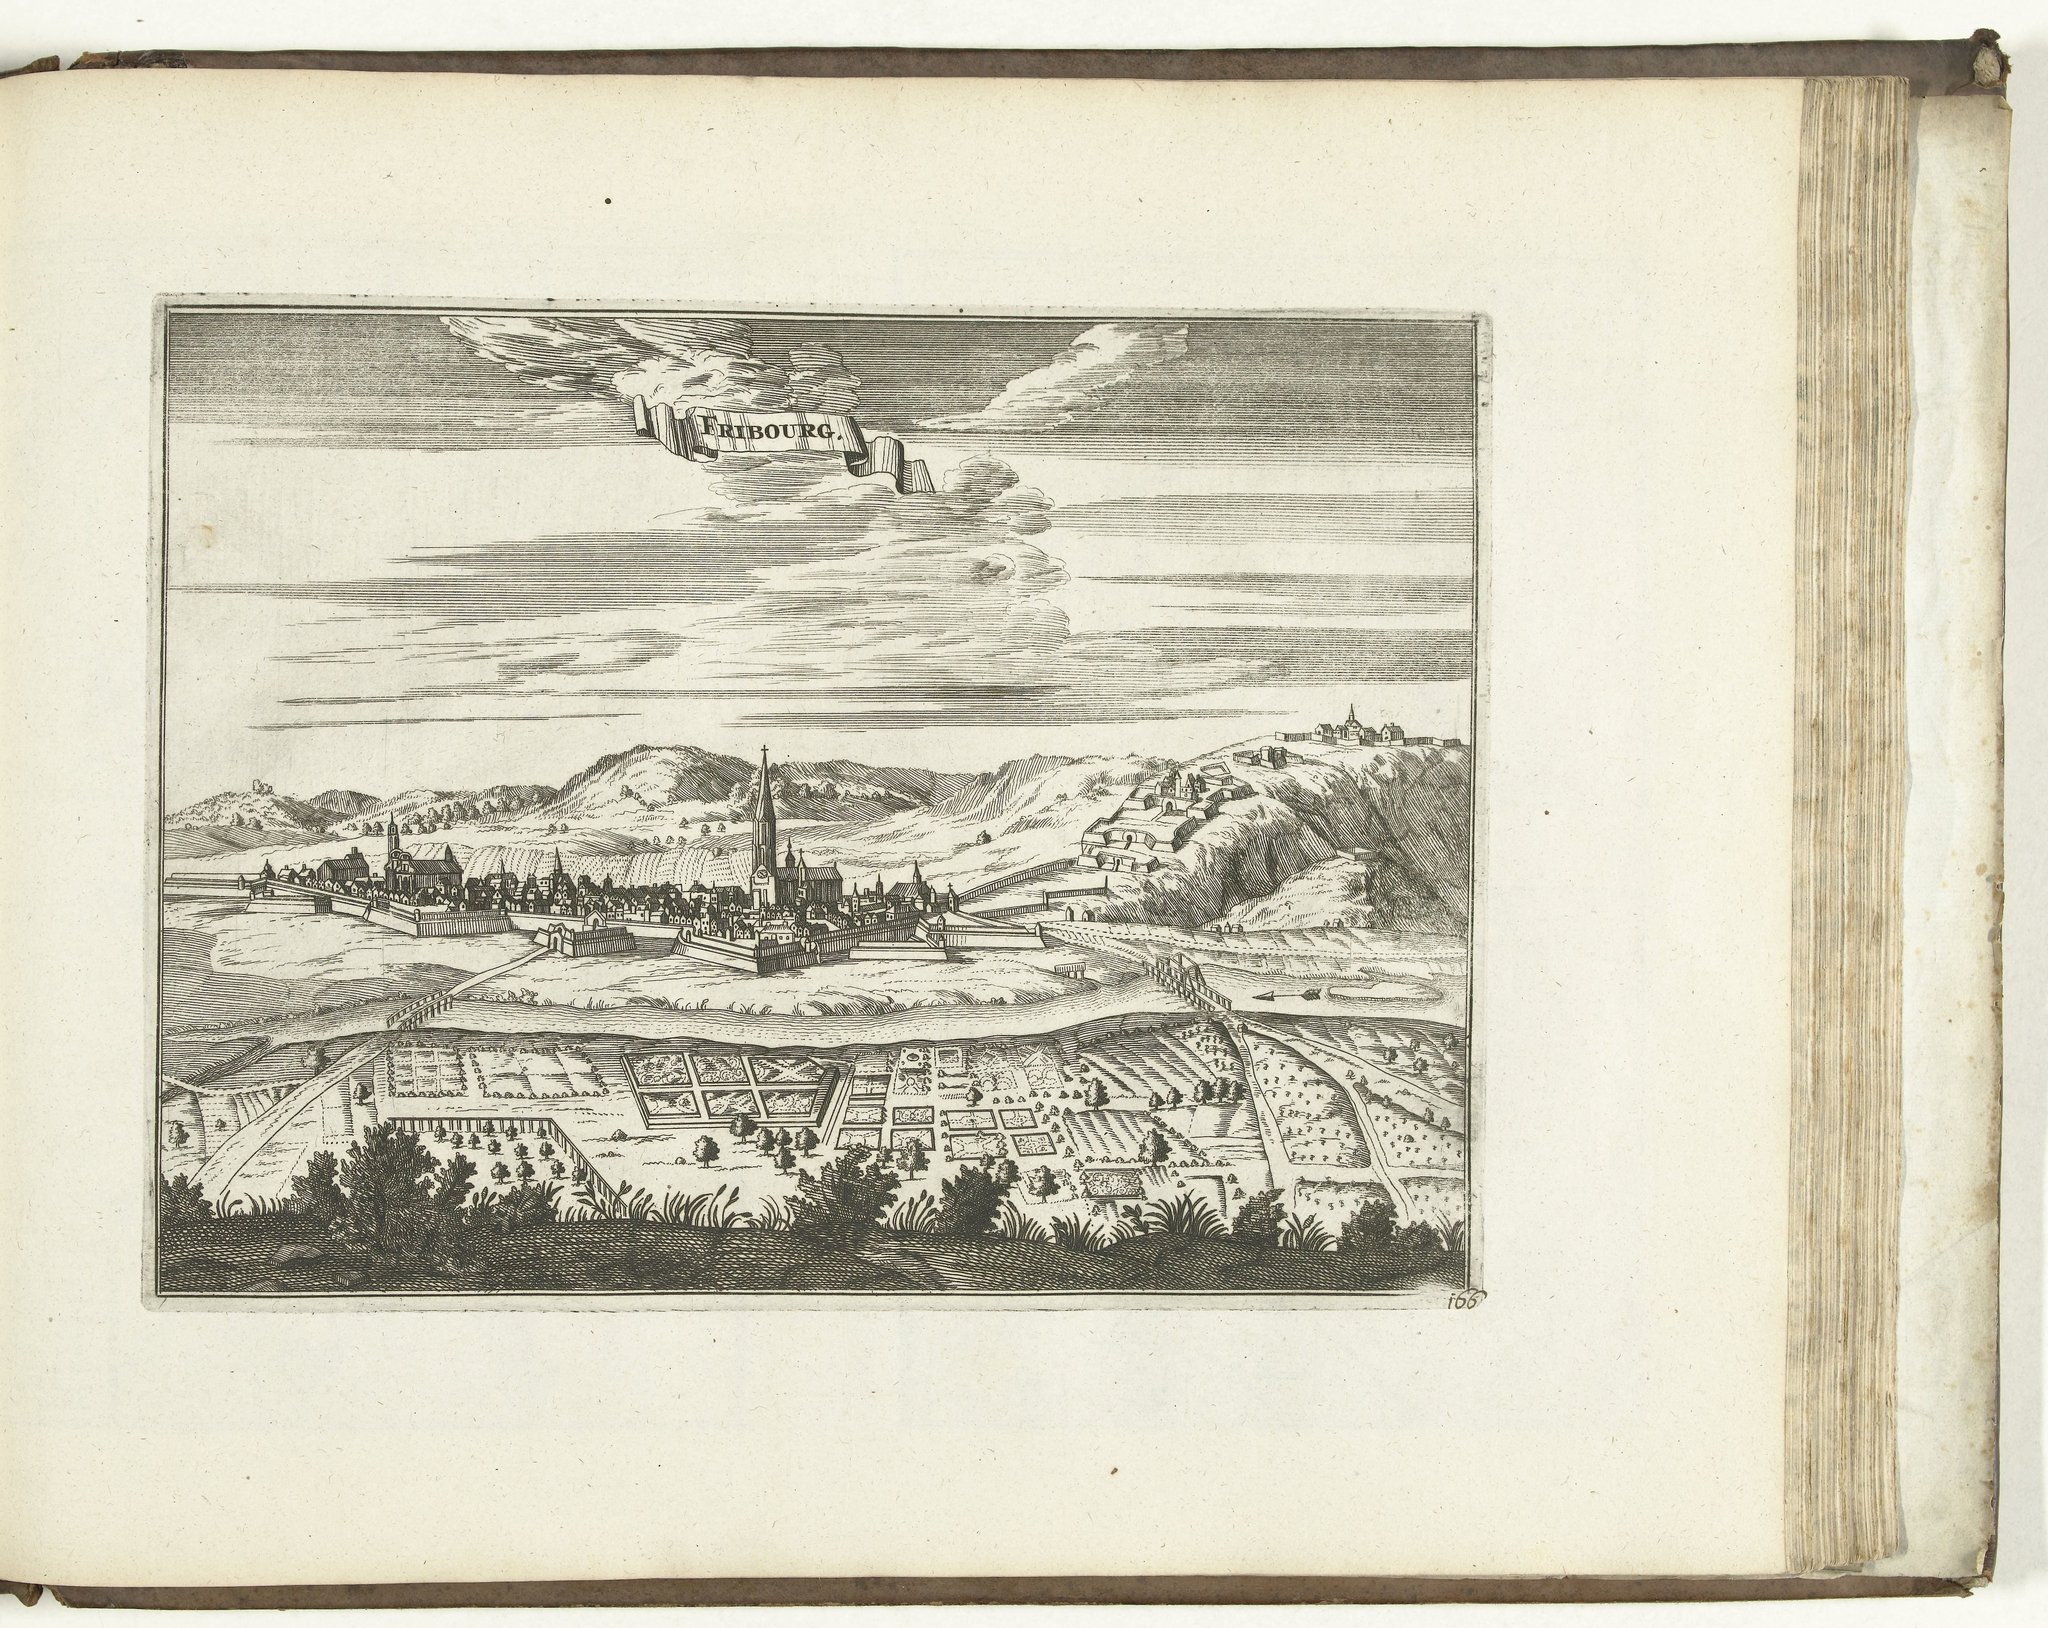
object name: print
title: Fribourg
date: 1726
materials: paper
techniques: etching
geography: northern netherlands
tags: fribourg, spaanse successieoorlog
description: Gezicht op de Zwitserse stad Fribourg. Plaat nr. 166 in deel VII van het prentwerk: Les Forces de l'Europe, Asie, Afrique et Amerique ... Comme aussi les Cartes des Côtes de France et d'Espagne uit 1726, dit eerste deel met 238 met de hand genummerde platen van vermaarde sterke steden en vestingen in het kader van de Spaanse Successieoorlog 1701-1713. Voor het merendeel zijn deze platen gekopieerd naar de anonieme Franse platen van vermaarde sterke steden en vestingen: in Les forces de l'Europe en in: Le theatre de la guerre, dans les Pays-Bas, beide oorspronkelijk uitgegeven door Nicolas de Fer te Parijs (1693-1697) in het kader van de Negenjarige Oorlog. Titel en opschriften in het Frans.